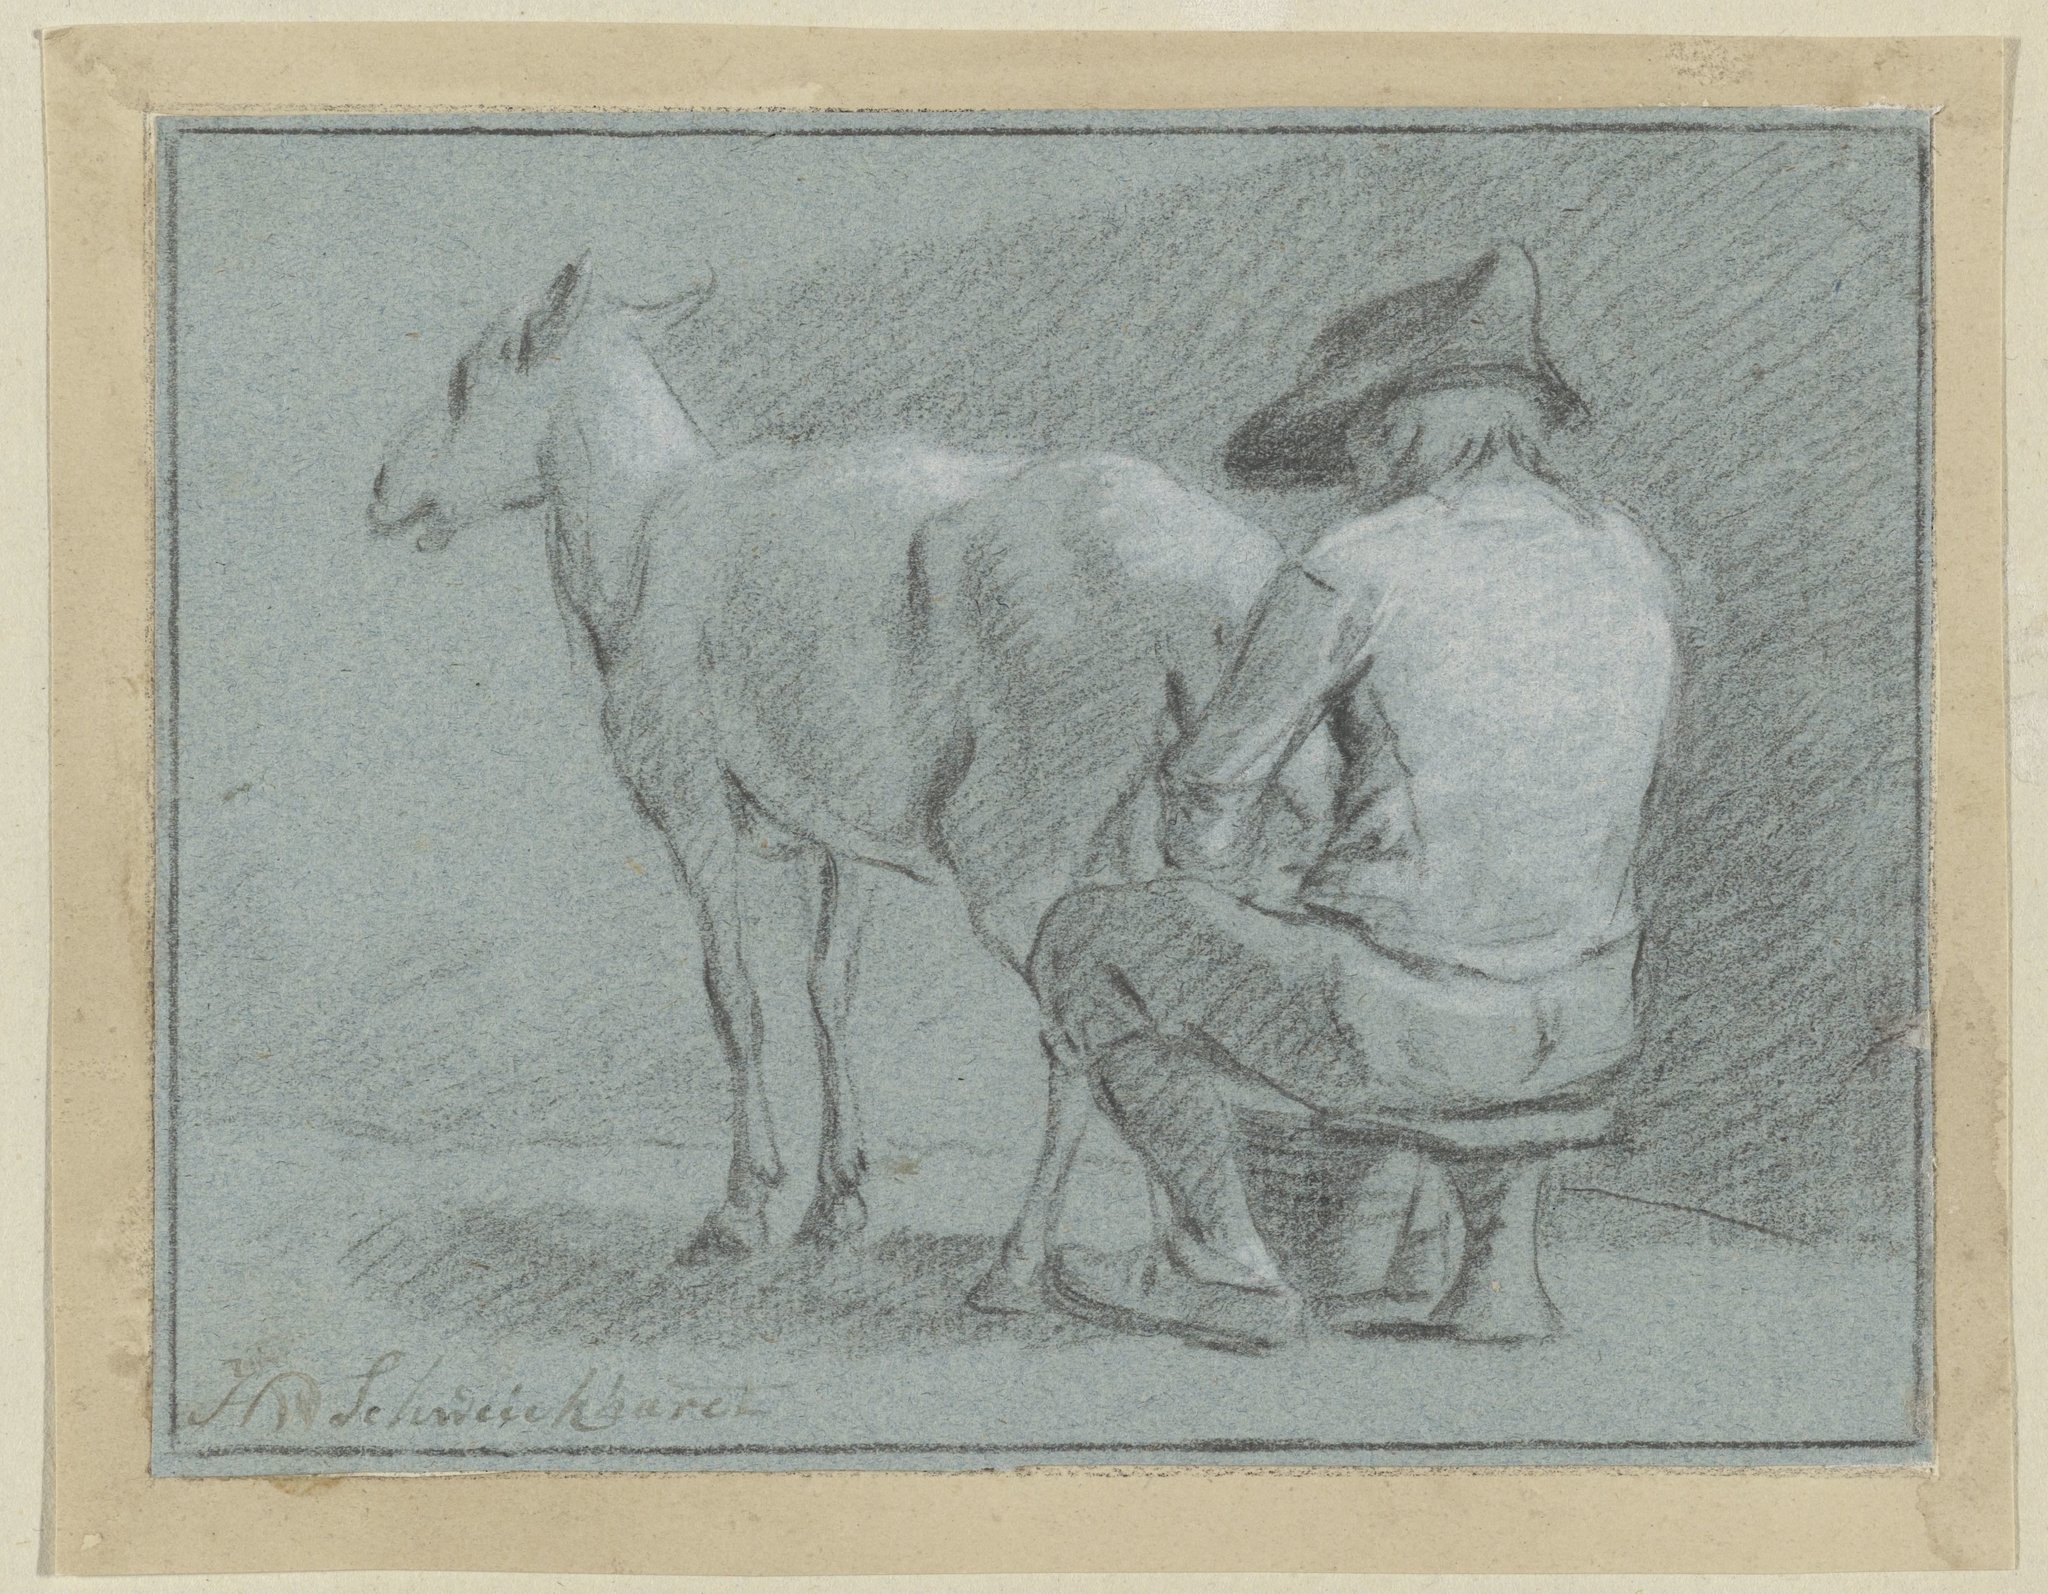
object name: drawing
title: Schaapmelkende man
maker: hendrik willem schweickhardt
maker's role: draughtsman, painter, print maker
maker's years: 1746-1797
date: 1756-1797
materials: chalk, paper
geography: netherlands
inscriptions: signature: ‘HW Schweickhardt’